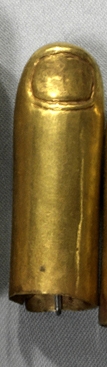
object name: finger stall, group 2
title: Finger stall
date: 1479-1425 BCE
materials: gold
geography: egypt